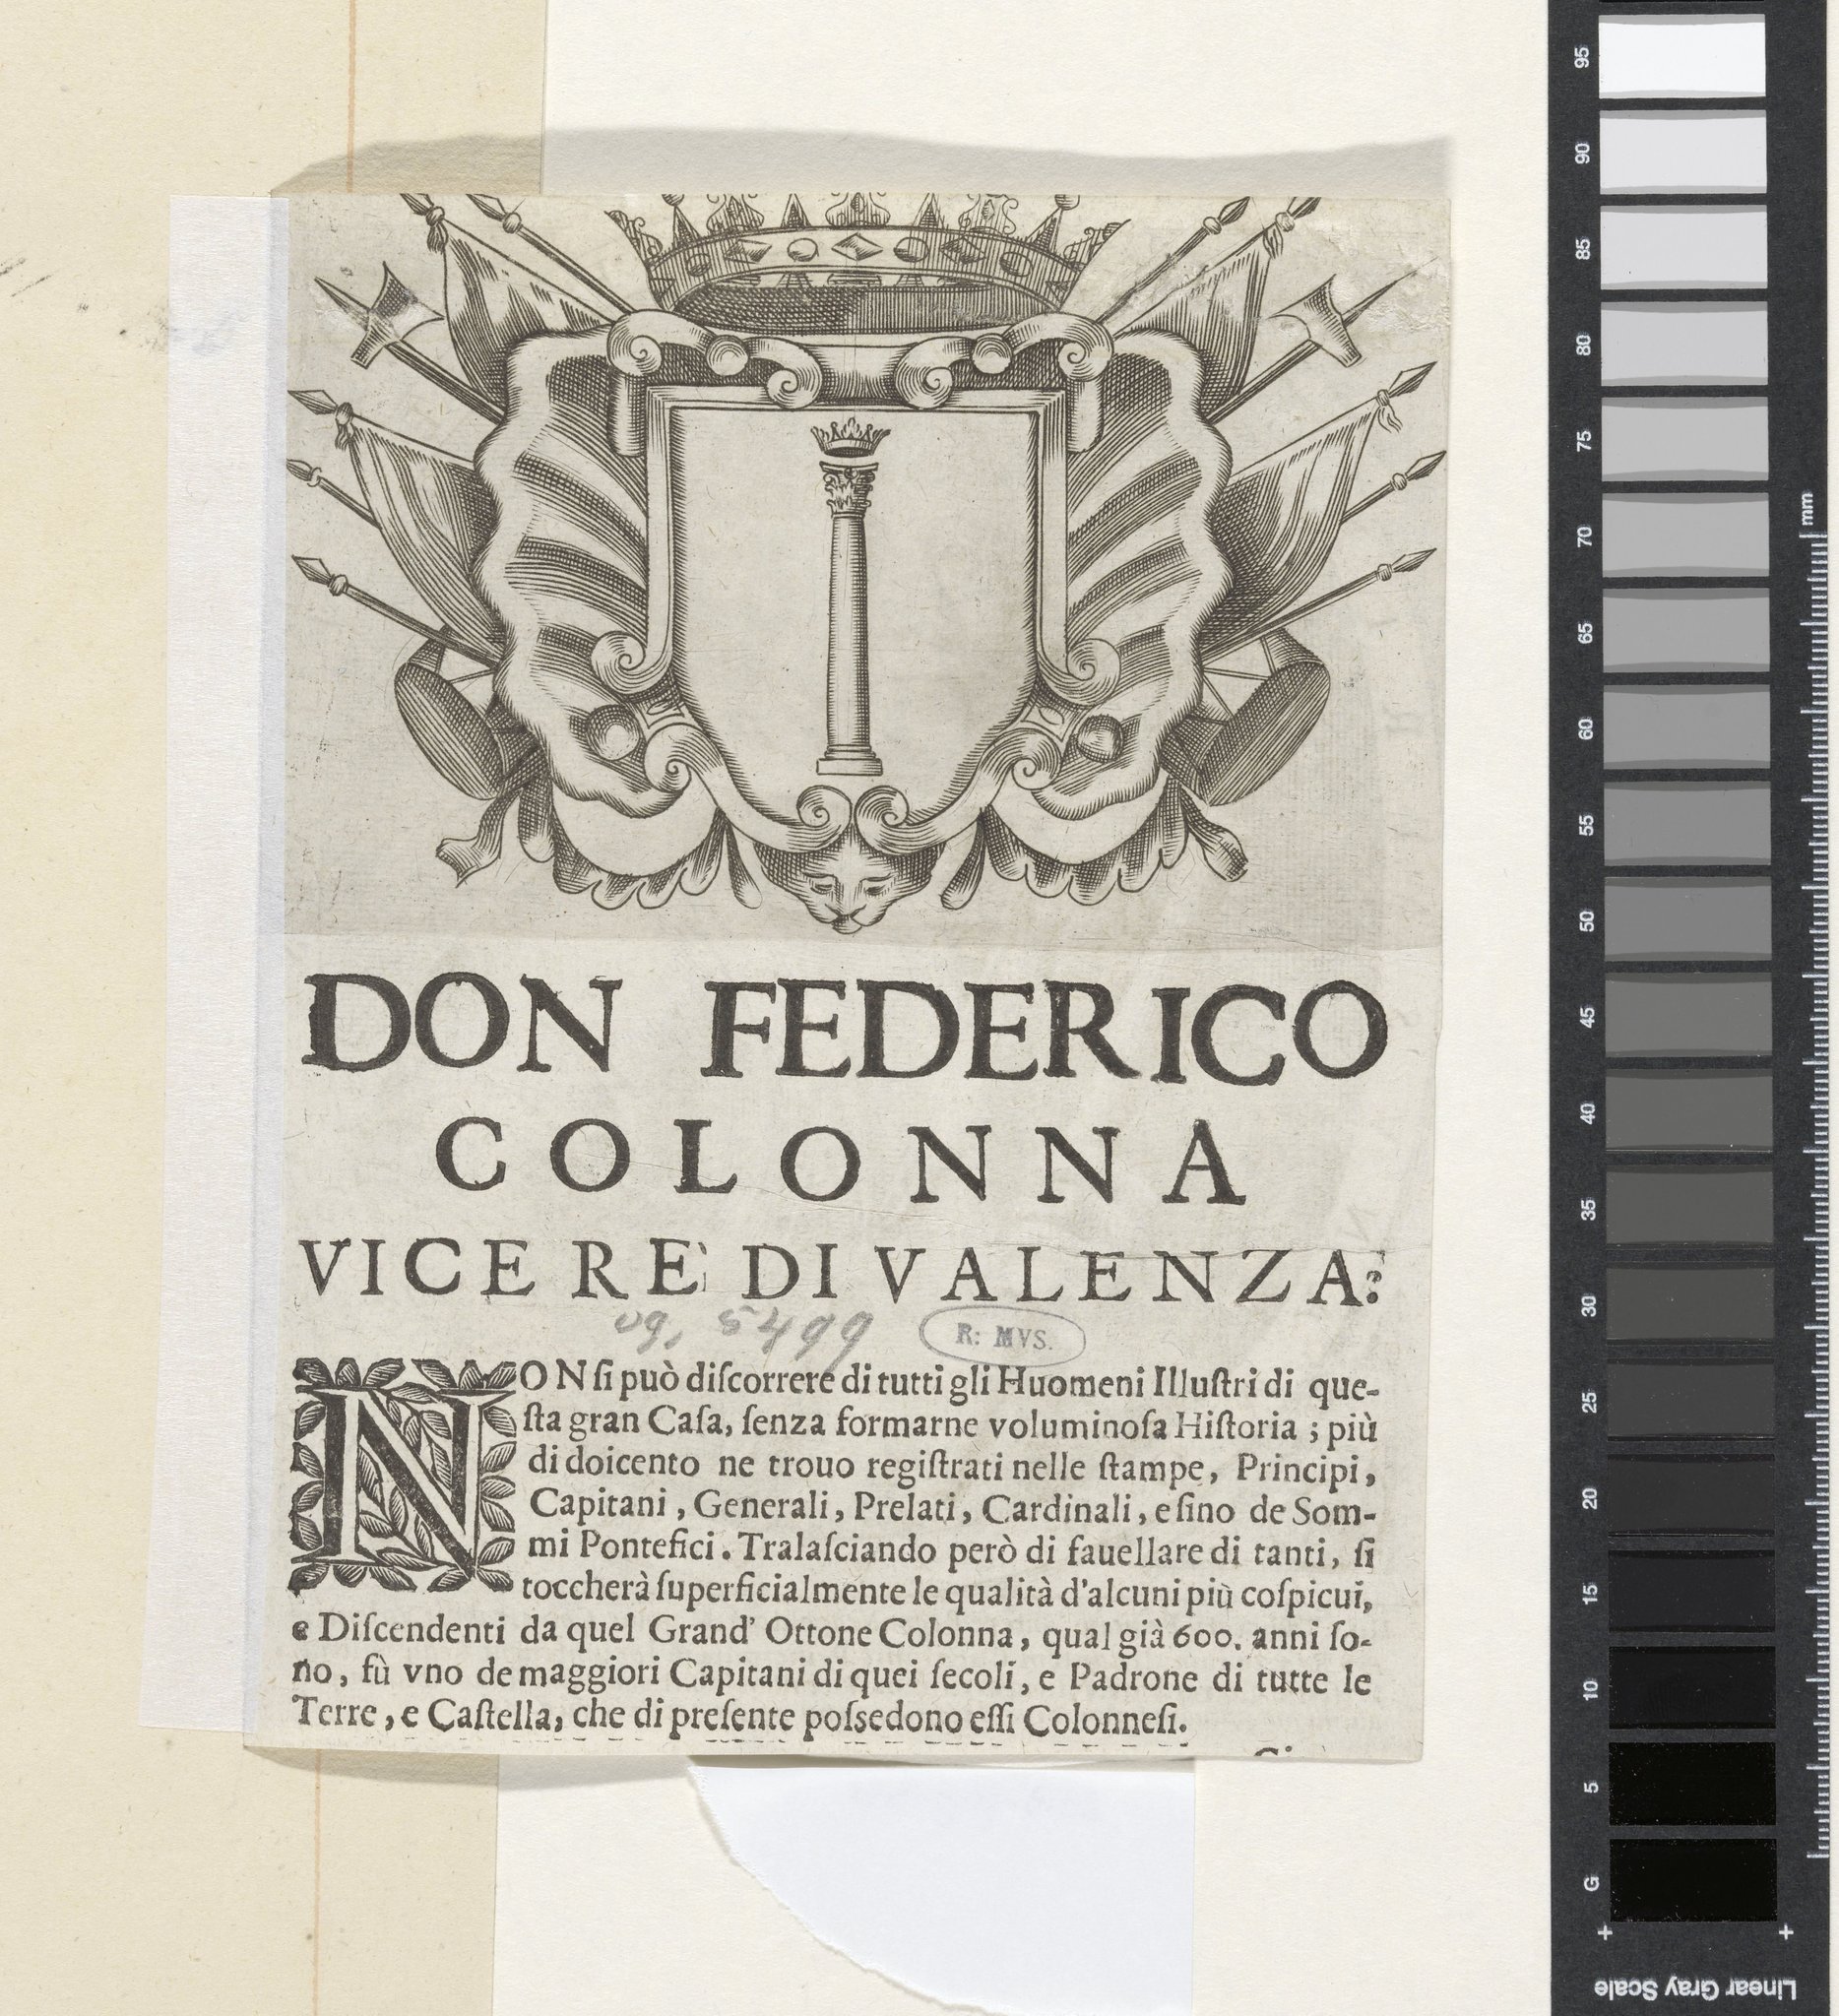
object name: print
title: Wapenschild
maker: camillo cungi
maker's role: print maker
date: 1597-1649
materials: paper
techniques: engraving, letterpress printing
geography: italy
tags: coat of arms (symbol of sovereignty)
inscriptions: collector's mark: Lugt 2228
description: Een wapenschild met daaronder tekst in boekdruk.